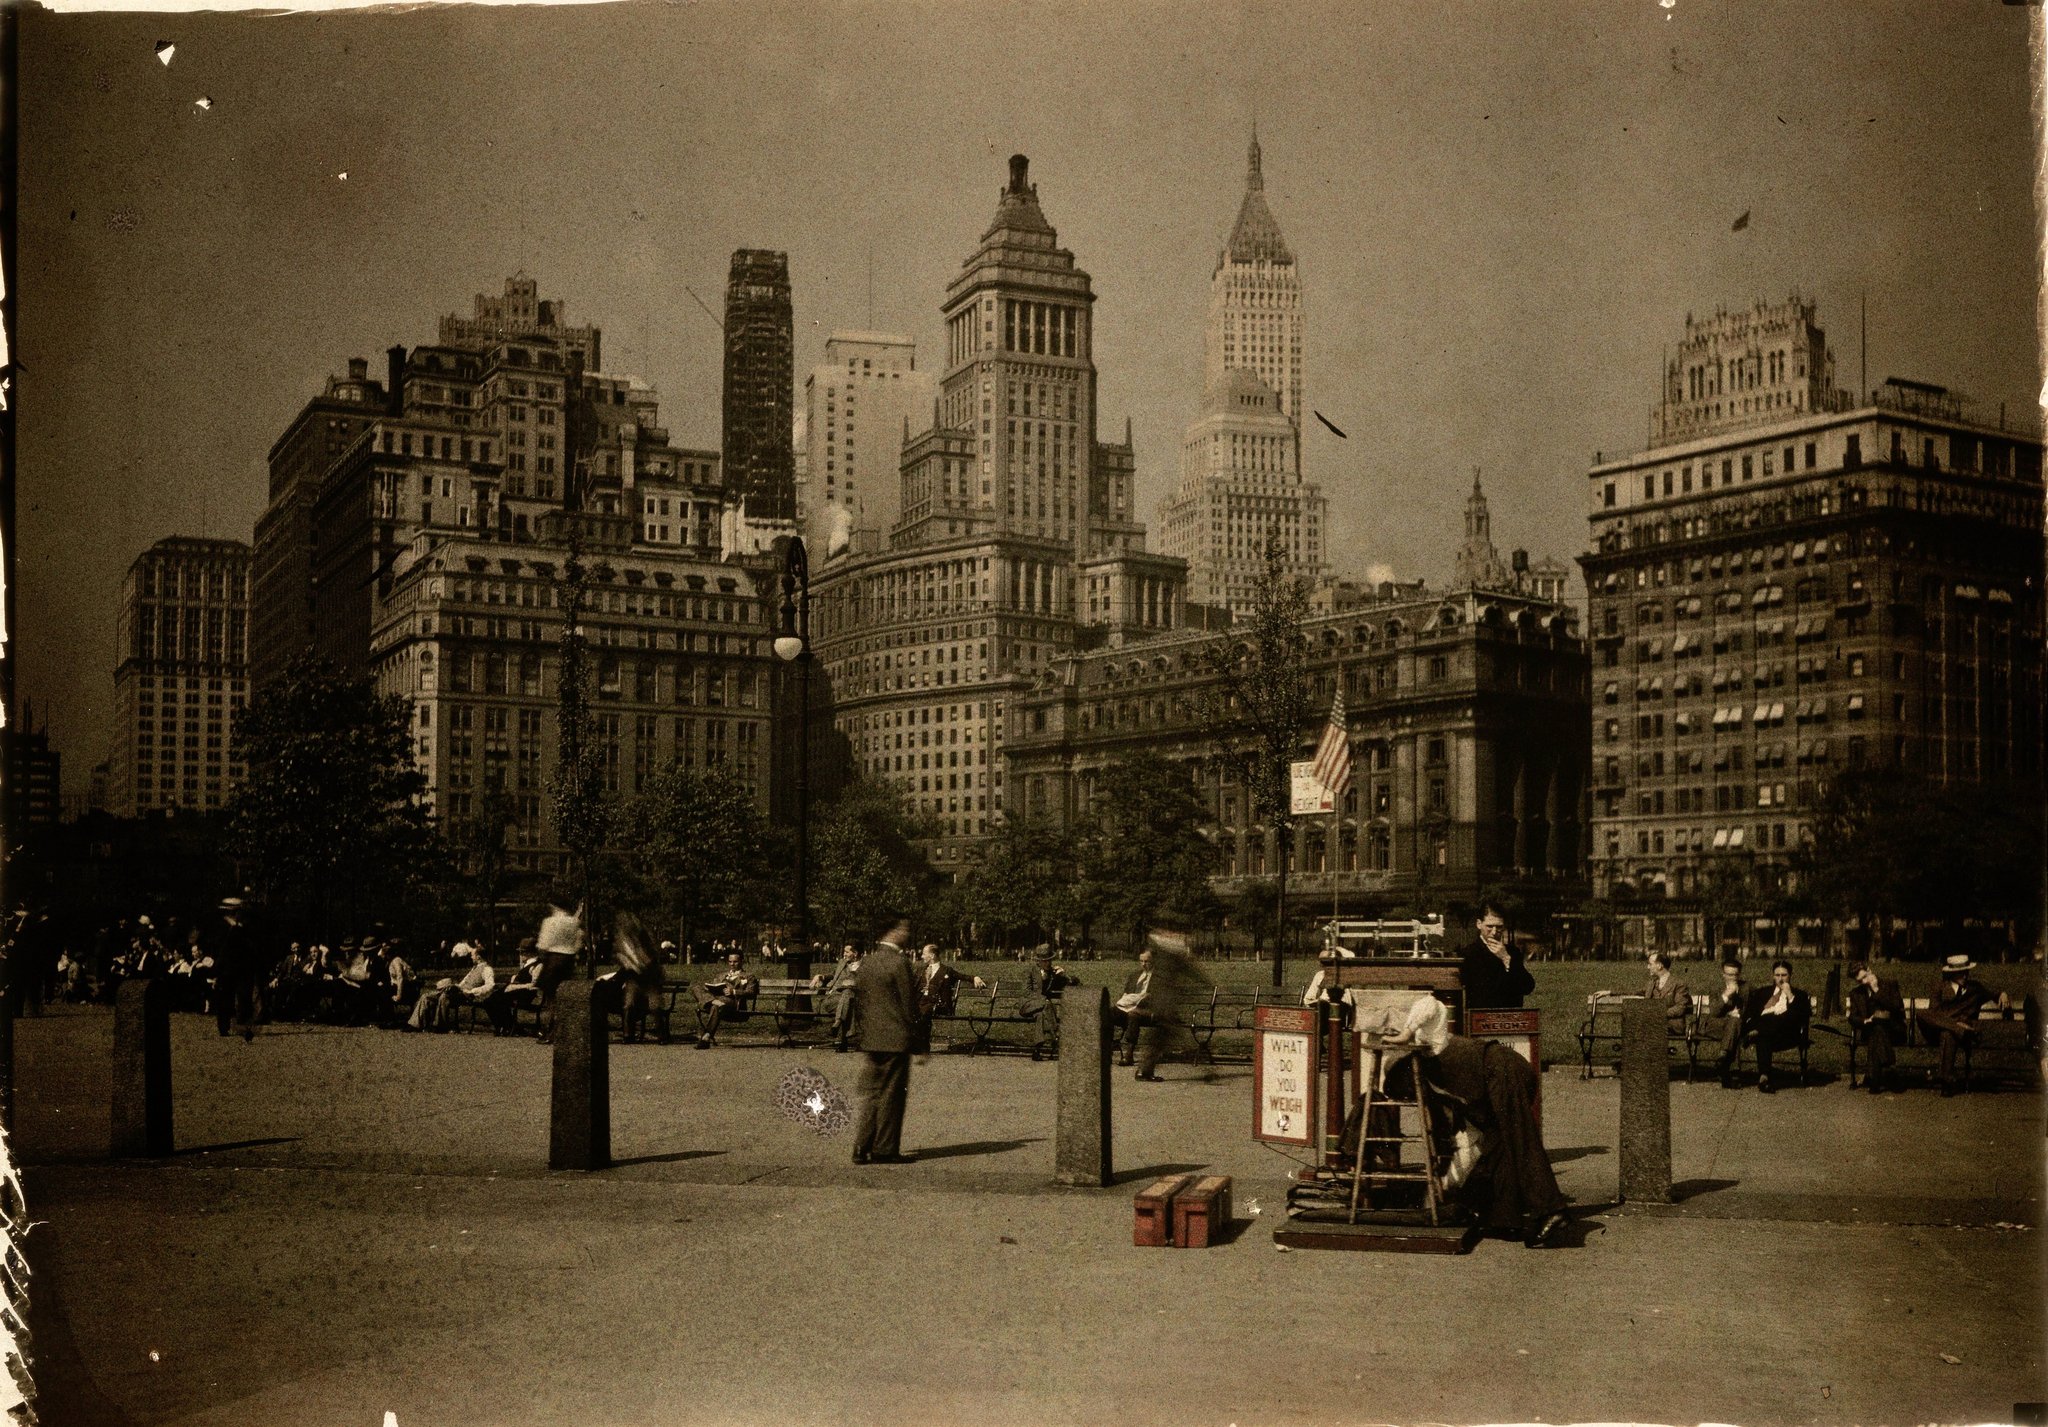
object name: photograph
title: Battery Park, New York City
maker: clifton r. adams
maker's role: fotograaf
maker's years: 1890-1934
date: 1920-1930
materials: glass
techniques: autochrome process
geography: new york city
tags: city-view, and landscape with man-made constructions - ii - ideal landscapes